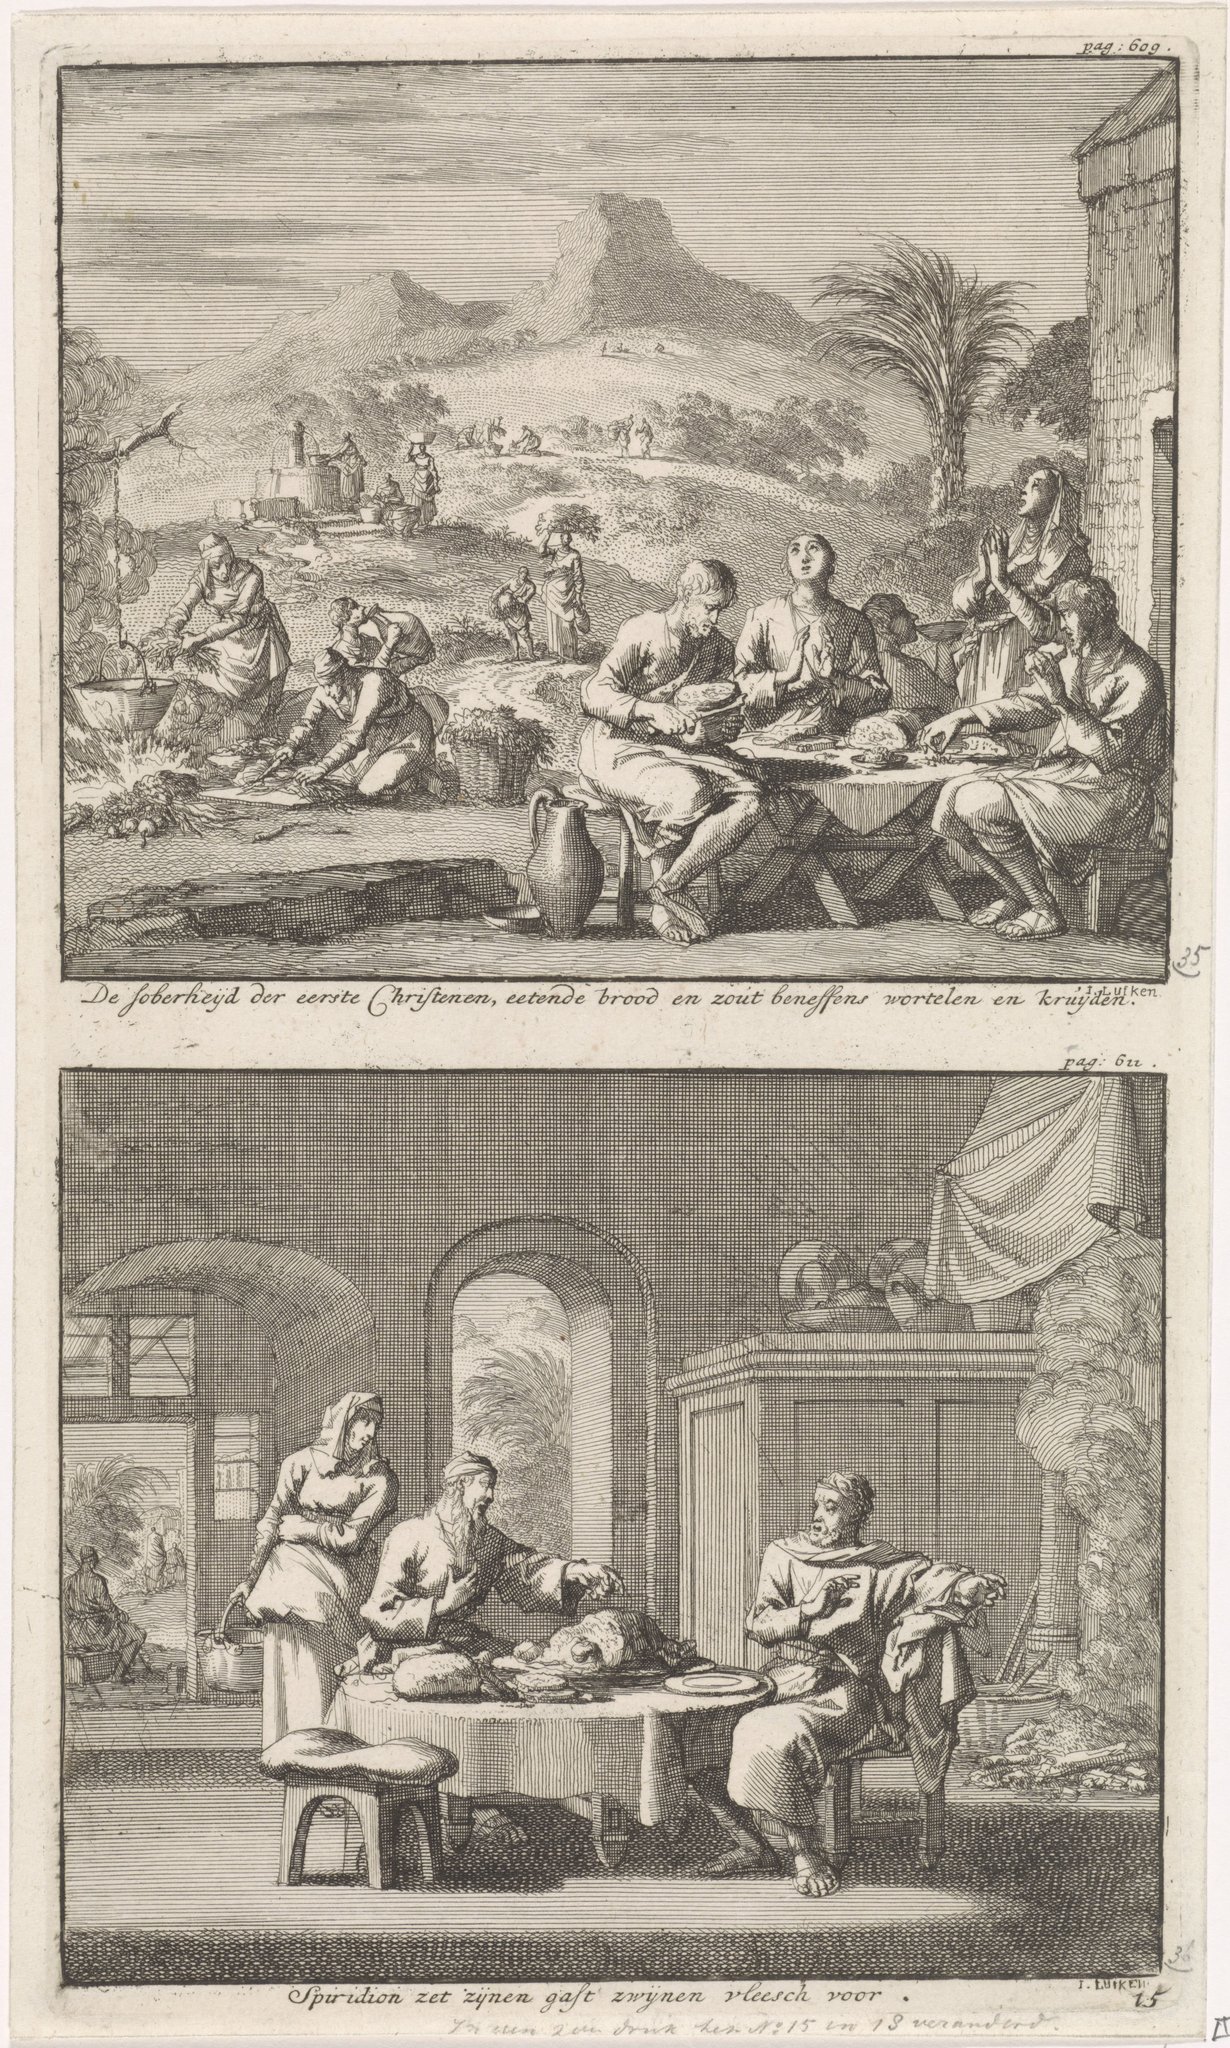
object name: book illustration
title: Sobere maaltijd van de eerste christenen en de heilige Spiridon van Cyprus die een gast gezouten varkensvlees aanbiedt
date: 1700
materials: paper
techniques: etching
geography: amsterdam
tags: the early christian churches, e.g. armenians, copts, syrians, fasting, abstinence from food ~ ascetic life, hospitality; 'hospitalità' (ripa), kinds of meat (with name), male saints (with name), bread, loaf, evening meal, dinner, supper, broth, soup, utilitarian, public pump or water fountain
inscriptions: collector's mark: Lugt 2228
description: Twee voorstellingen op een plaat. Boven: op de voorgrond zitten enkele vroege christenen rond een tafel. Ze danken God voor de eenvoudige maaltijd en eten brood. Op de achtergrond wordt soep gekookt en wordt water uit een bron gehaald. Onder: de H. Spiridon van Cyprus zit aan tafel met een gast. Hij biedt zijn gast gezouten varkensvlees aan, maar deze weigert omdat hij aan het vasten is.